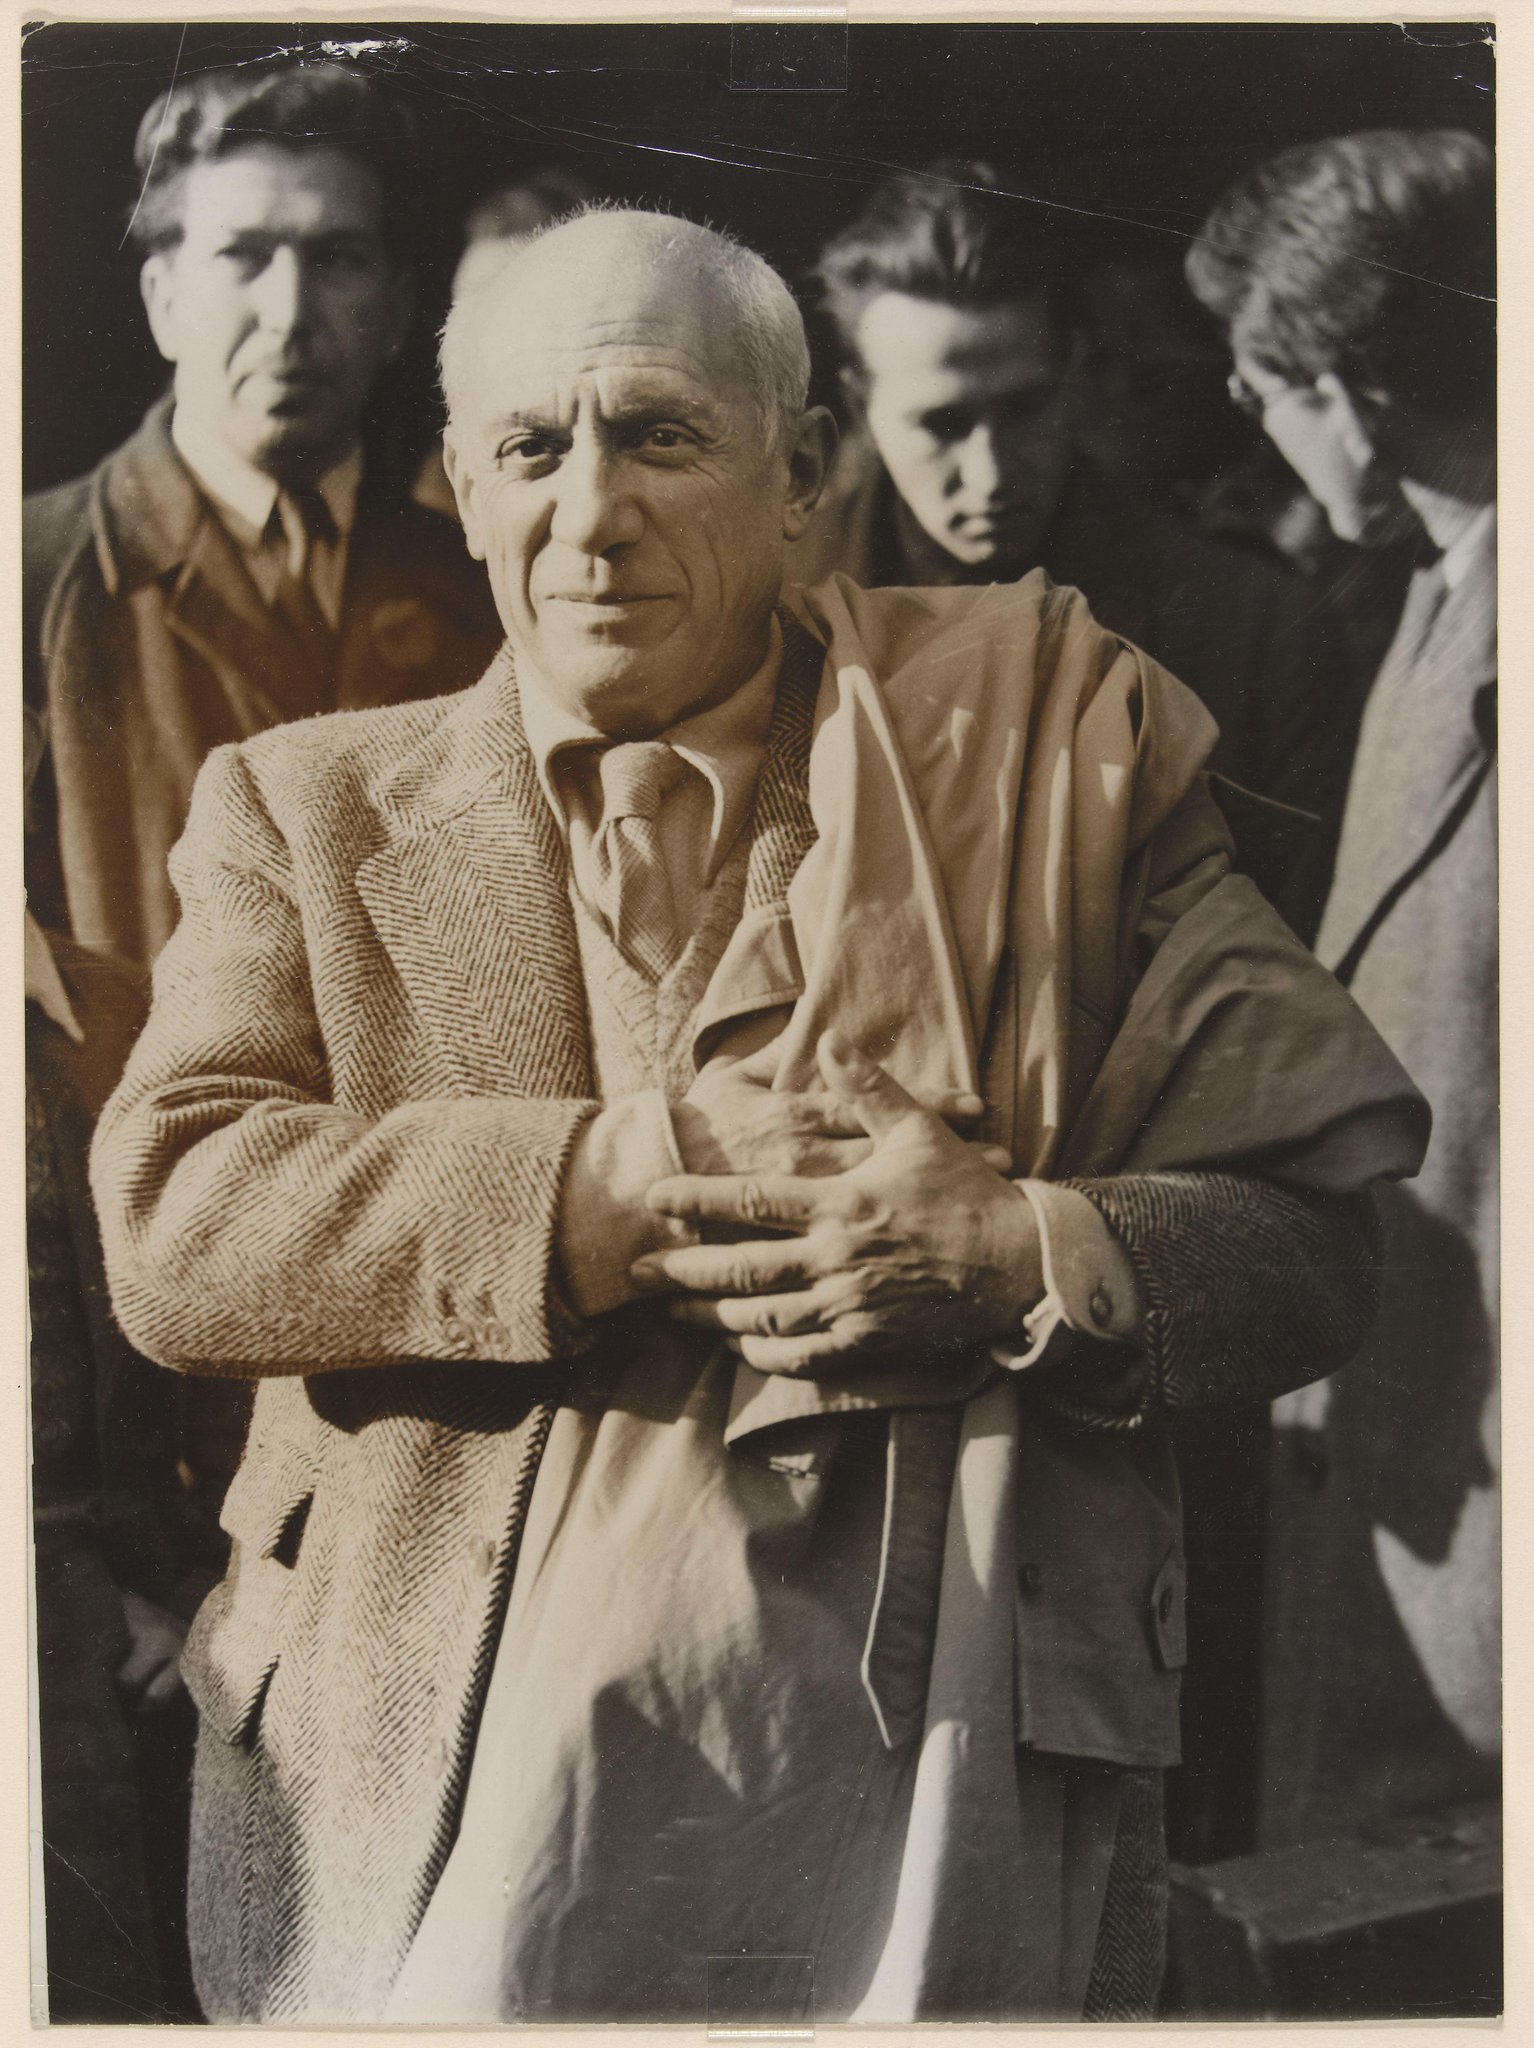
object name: photograph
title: Pablo Picasso bij aankomst op Victoria Station, voor de communistische vredesconferentie in Sheffield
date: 1950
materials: photographic support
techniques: gelatin silver print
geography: london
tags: print maker, pablo picasso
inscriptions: annotation: ‘Keystone photo shows; Picasso seen on his arrival at Victoria that morning JSS/KEYSTONE TRA/568648’, annotation: ‘Surrealist artist arrives for the communist "peace" conference... Picasso at Victoria.. 11-11-50. Among the arrivals at Victoria that morning for the communist controlled and inspired "Peace" conference to be held in Sheffield next week was Picasso the surrealist artist...’, stamp: ‘Keystone press agency ltd 4-7, Red Lion Court ...Street, London E.C.L.’